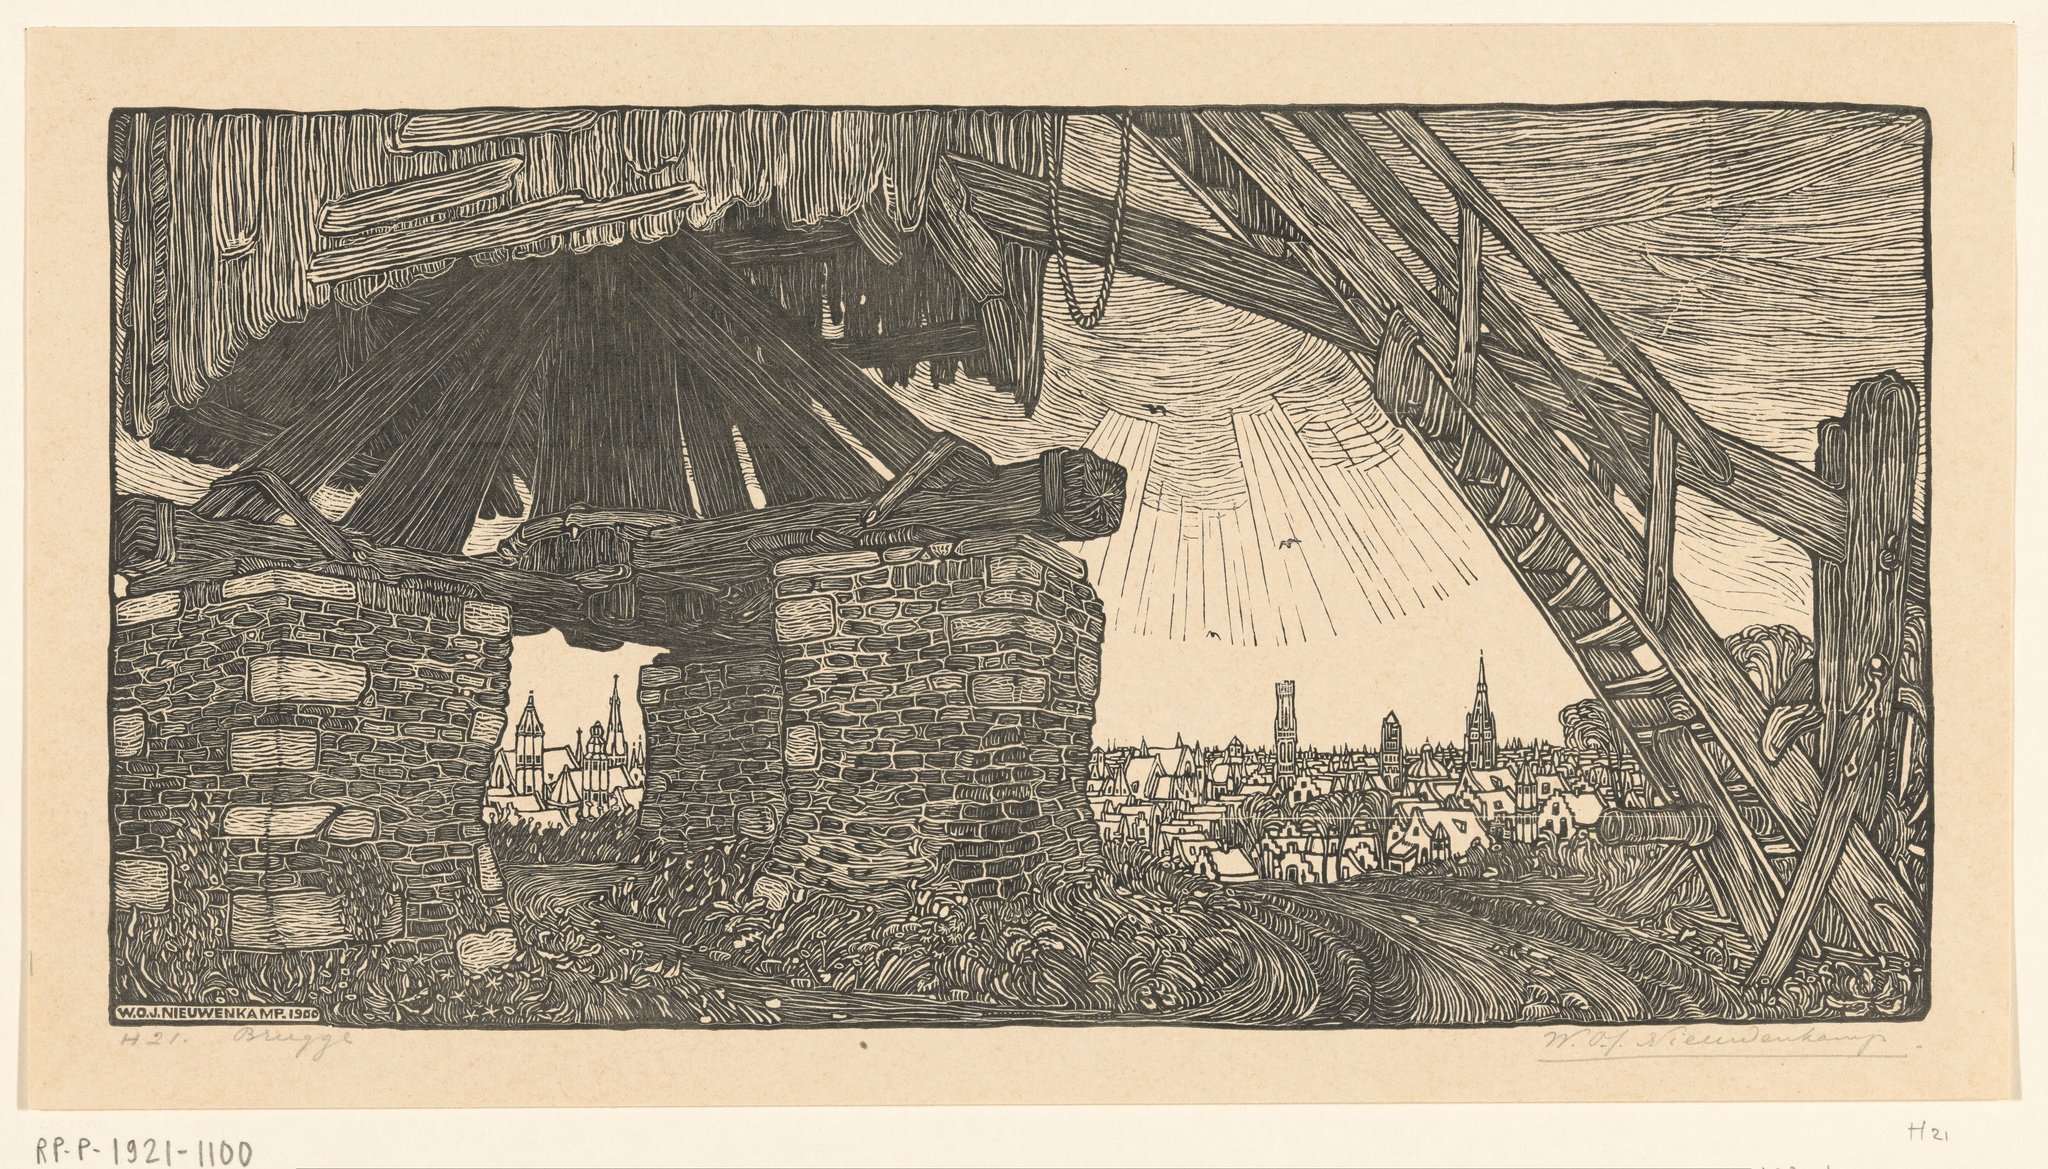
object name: print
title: Brugge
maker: wijnand otto jan nieuwenkamp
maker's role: draughtsman, print maker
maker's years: 1874-1950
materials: paper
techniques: woodcut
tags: city-view in general; 'veduta', windmill in landscape, bruges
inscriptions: collector's mark: Lugt 2233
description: Op de achtergrond het silhouet van Brugge.